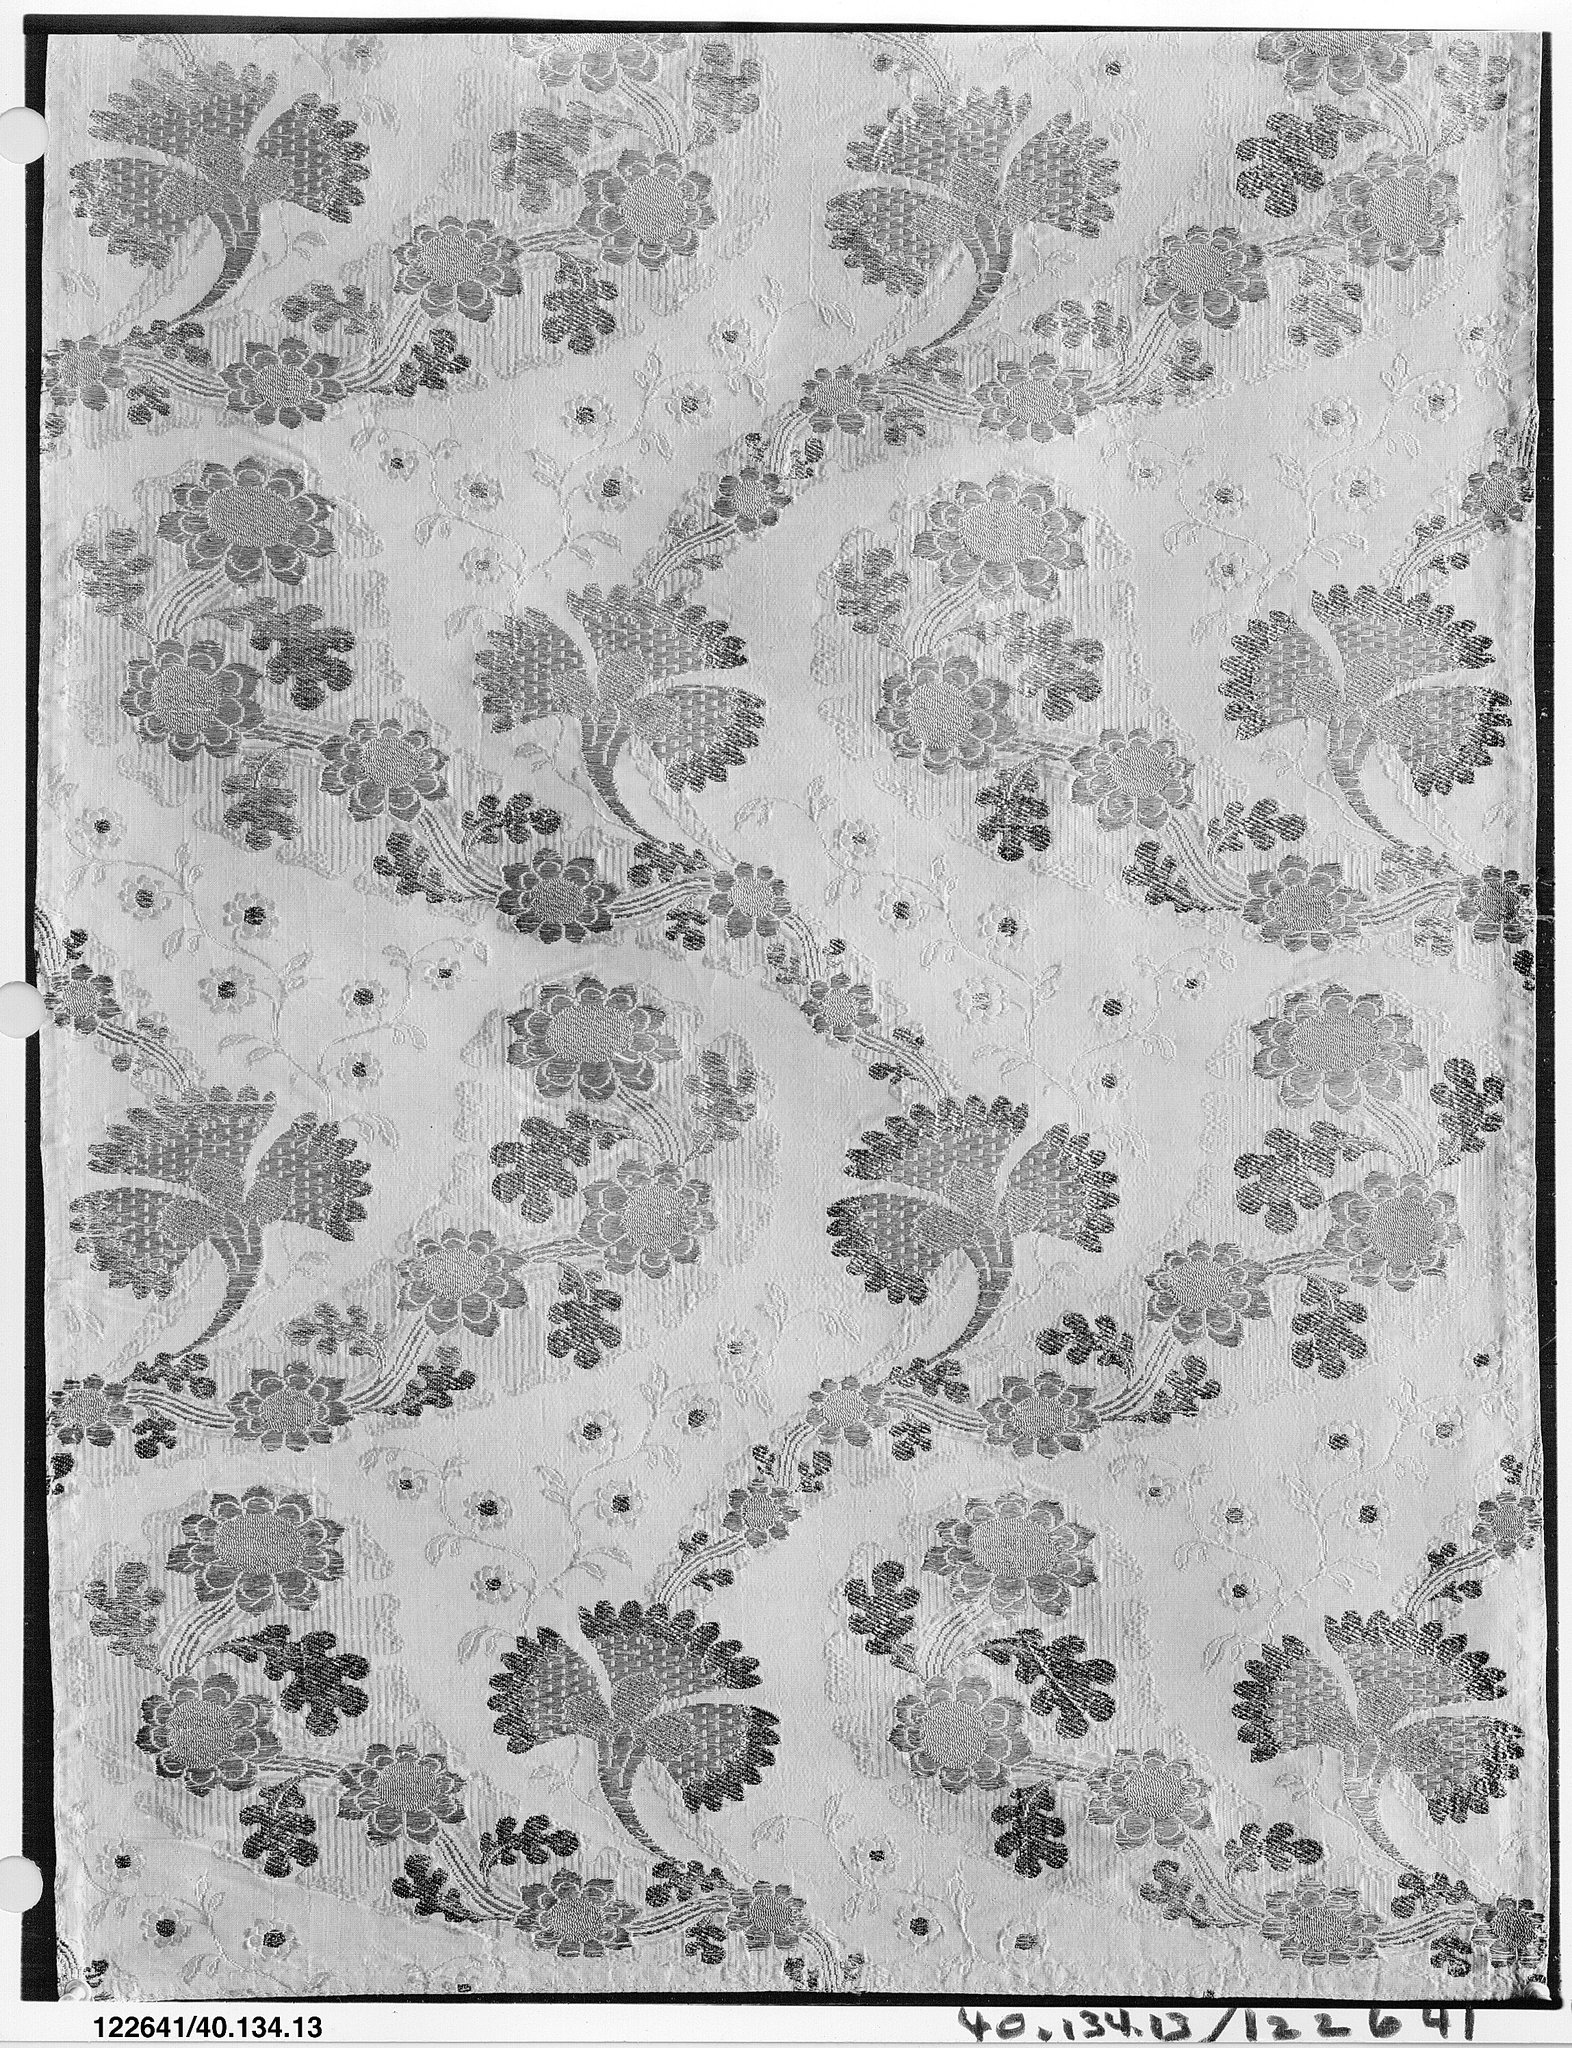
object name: piece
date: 1734-1766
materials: metal thread, silk